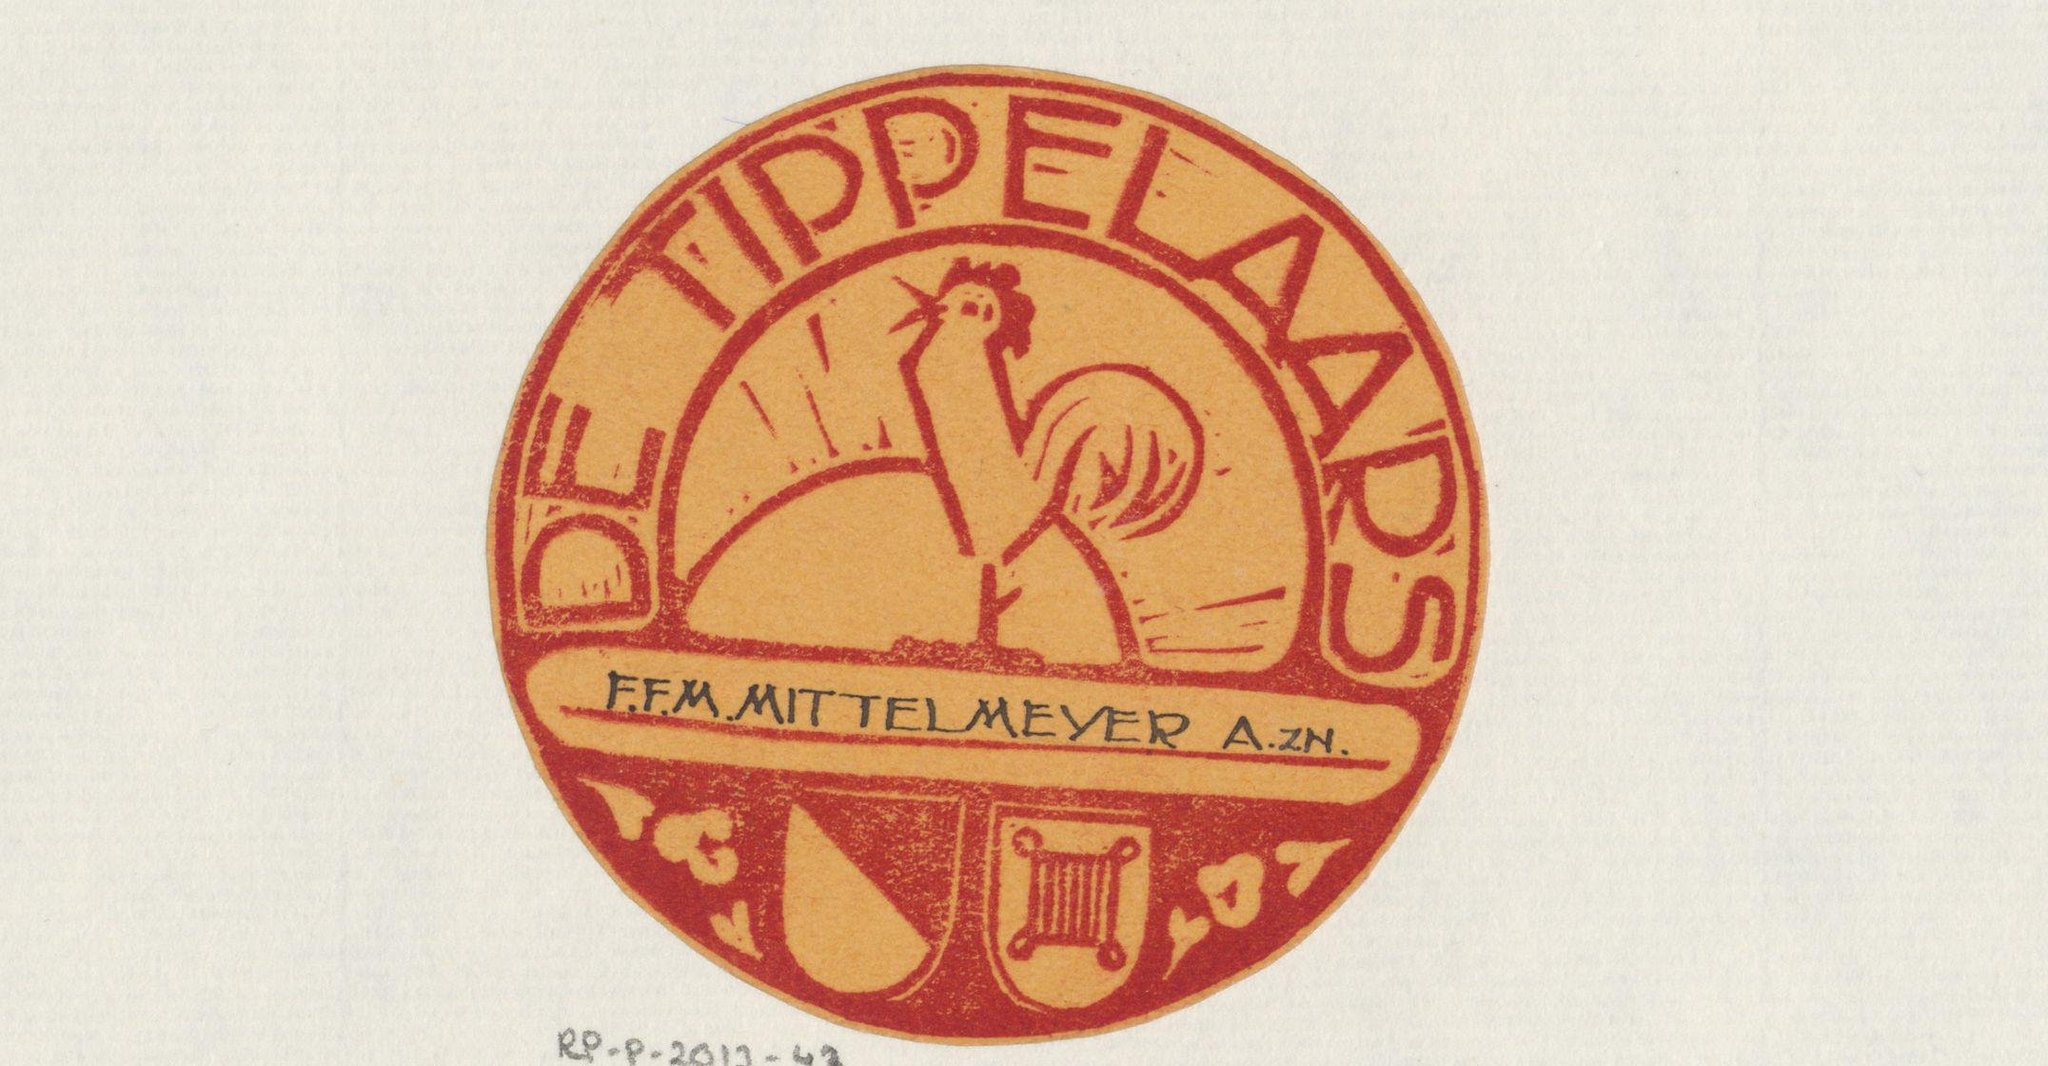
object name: bookplate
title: Ex libris van F.F.M. Mittelmeyer Azn.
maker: f.f.m. mittelmeyer azn.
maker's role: print maker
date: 1900-1999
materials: paper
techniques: linocut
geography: netherlands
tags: f.f.m. mittelmeyer azn., fowl (cock, hen, chicken, etc.), armorial bearing, heraldry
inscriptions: inscription: ‘ipse lino’